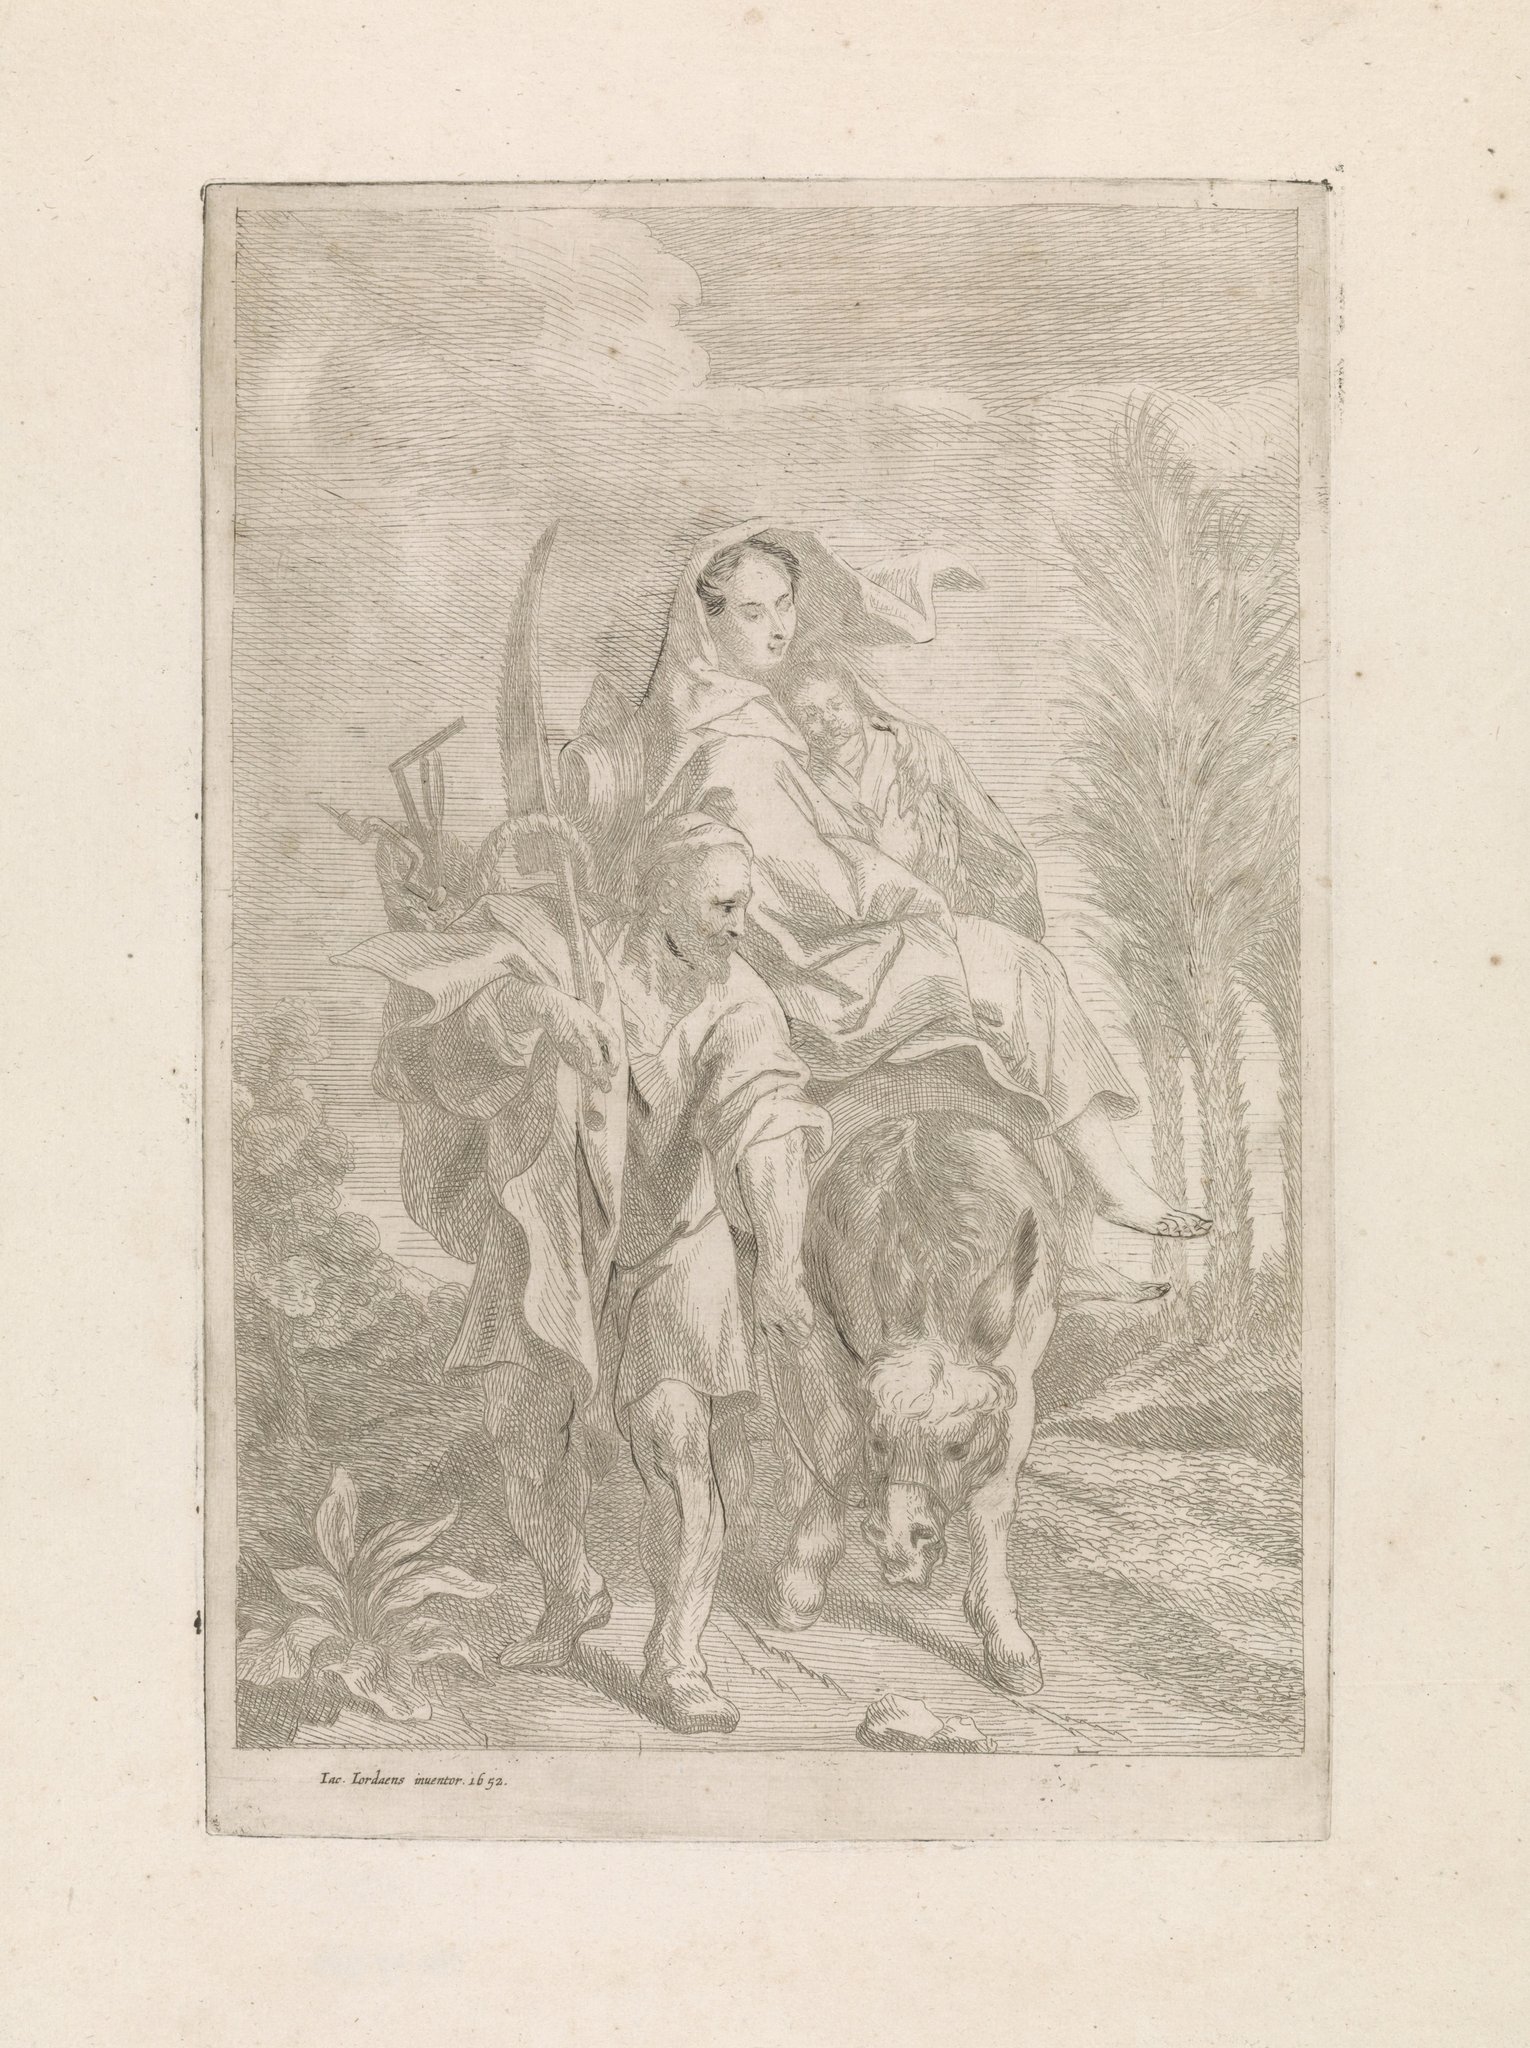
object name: print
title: De vlucht naar Egypte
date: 1652-1702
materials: paper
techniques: engraving, etching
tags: the flight into egypt: mary, joseph, the child (and sometimes others) on their way; mary usually riding on an ass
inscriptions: collector's mark: Lugt 240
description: Jozef leidt de ezel met Maria en het Christuskind over een pad door een landschap. Rechts van het pad staan drie palmen.